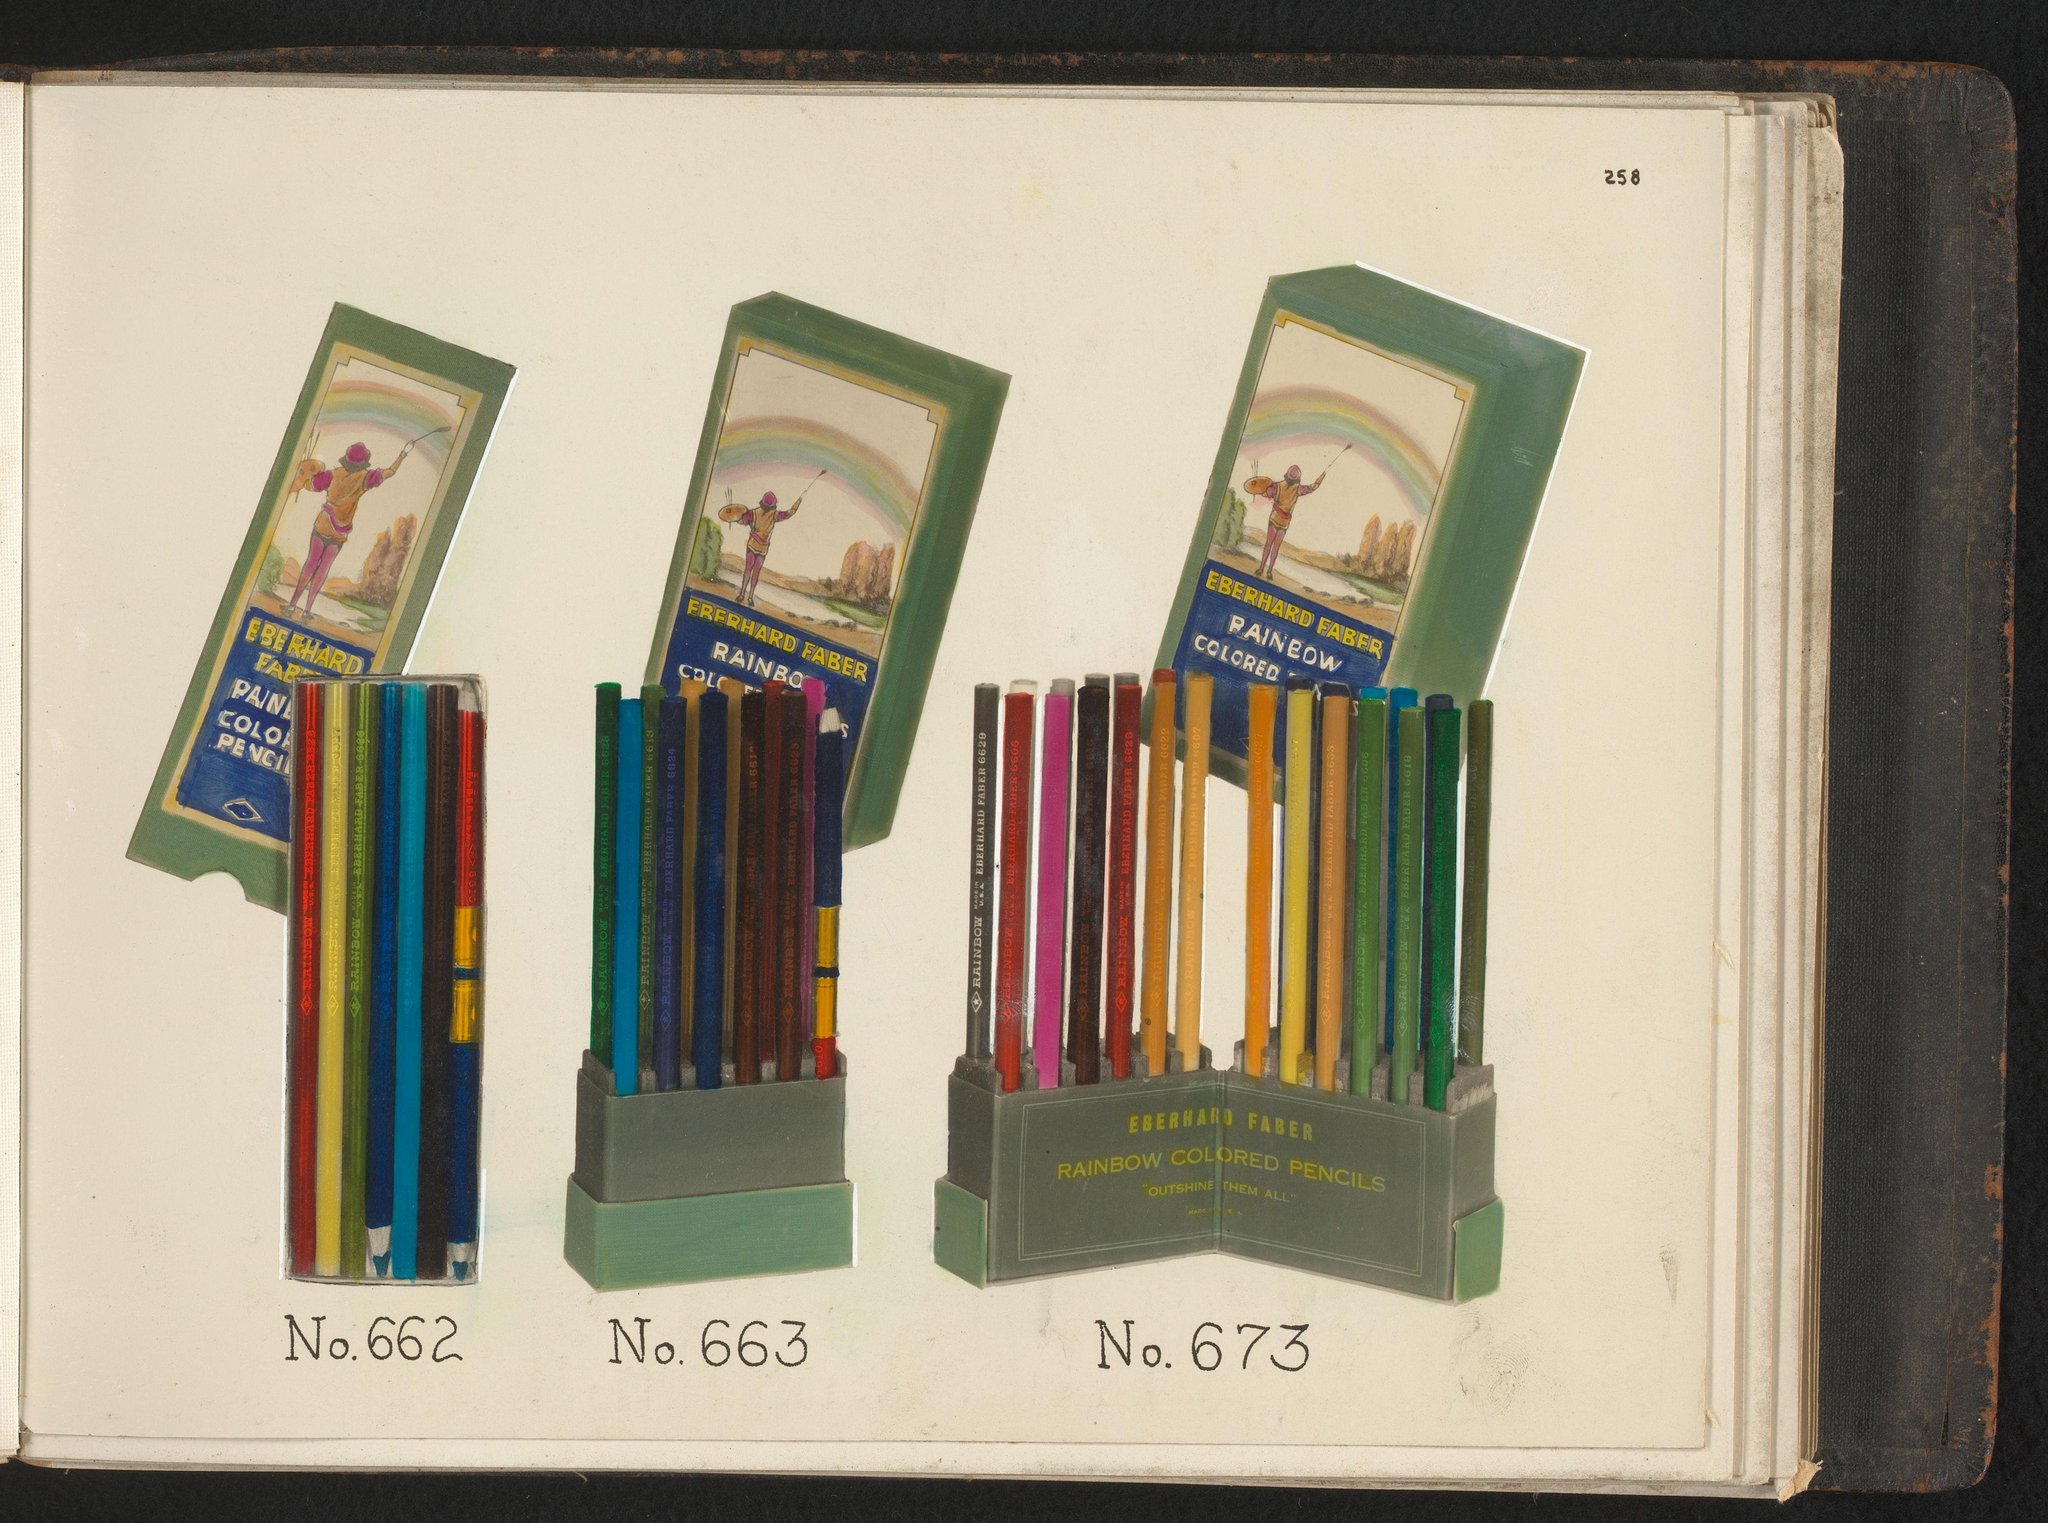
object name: album leaf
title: Sets met kleurpotloden van Eberhard Faber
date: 1915-1935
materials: paper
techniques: gelatin silver print, hand coloring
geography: springfield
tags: pencil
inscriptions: stamp: ‘Paramount/ Commercial Studios/ 145 Chestnut St./ Springfield - Mass.’, number: ‘258’